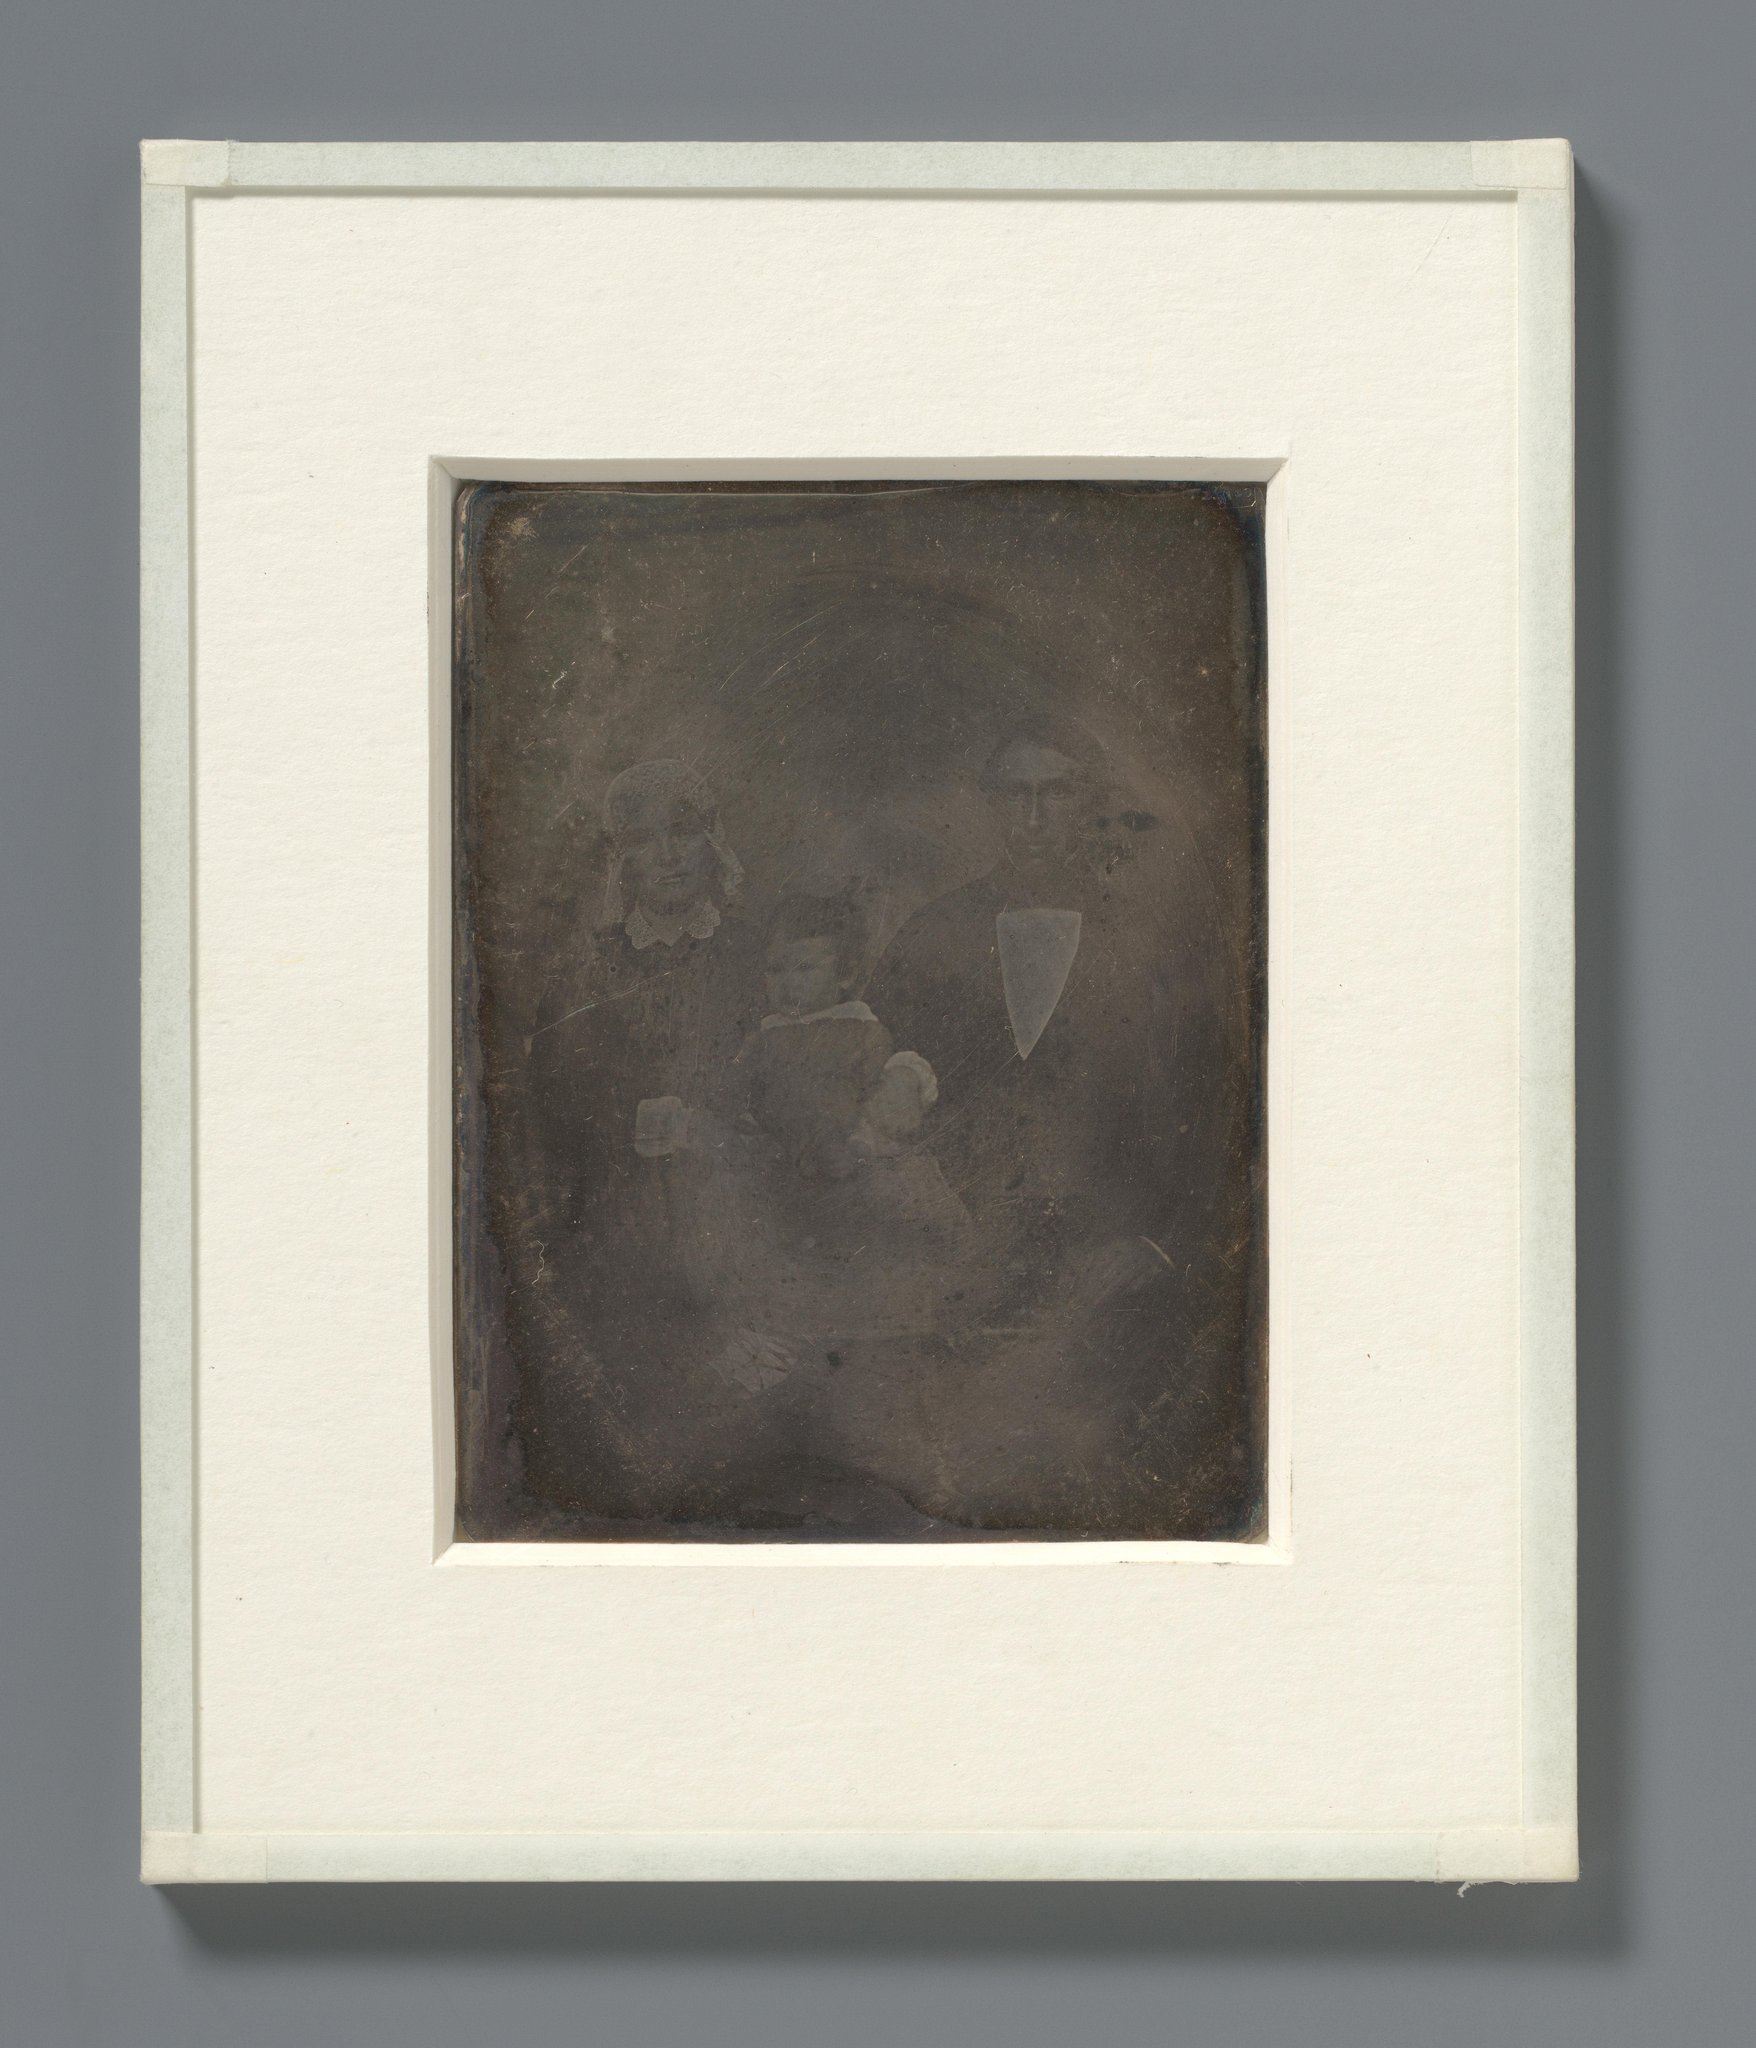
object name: photograph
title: Portret van een onbekend echtpaar met kind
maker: Anonymous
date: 1840-1850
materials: copper, glass, paper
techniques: daguerreotype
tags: parents with their children, historical persons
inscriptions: inscription: ‘ingelijst door Michiel Kort’, mark: ‘H.B. _30’